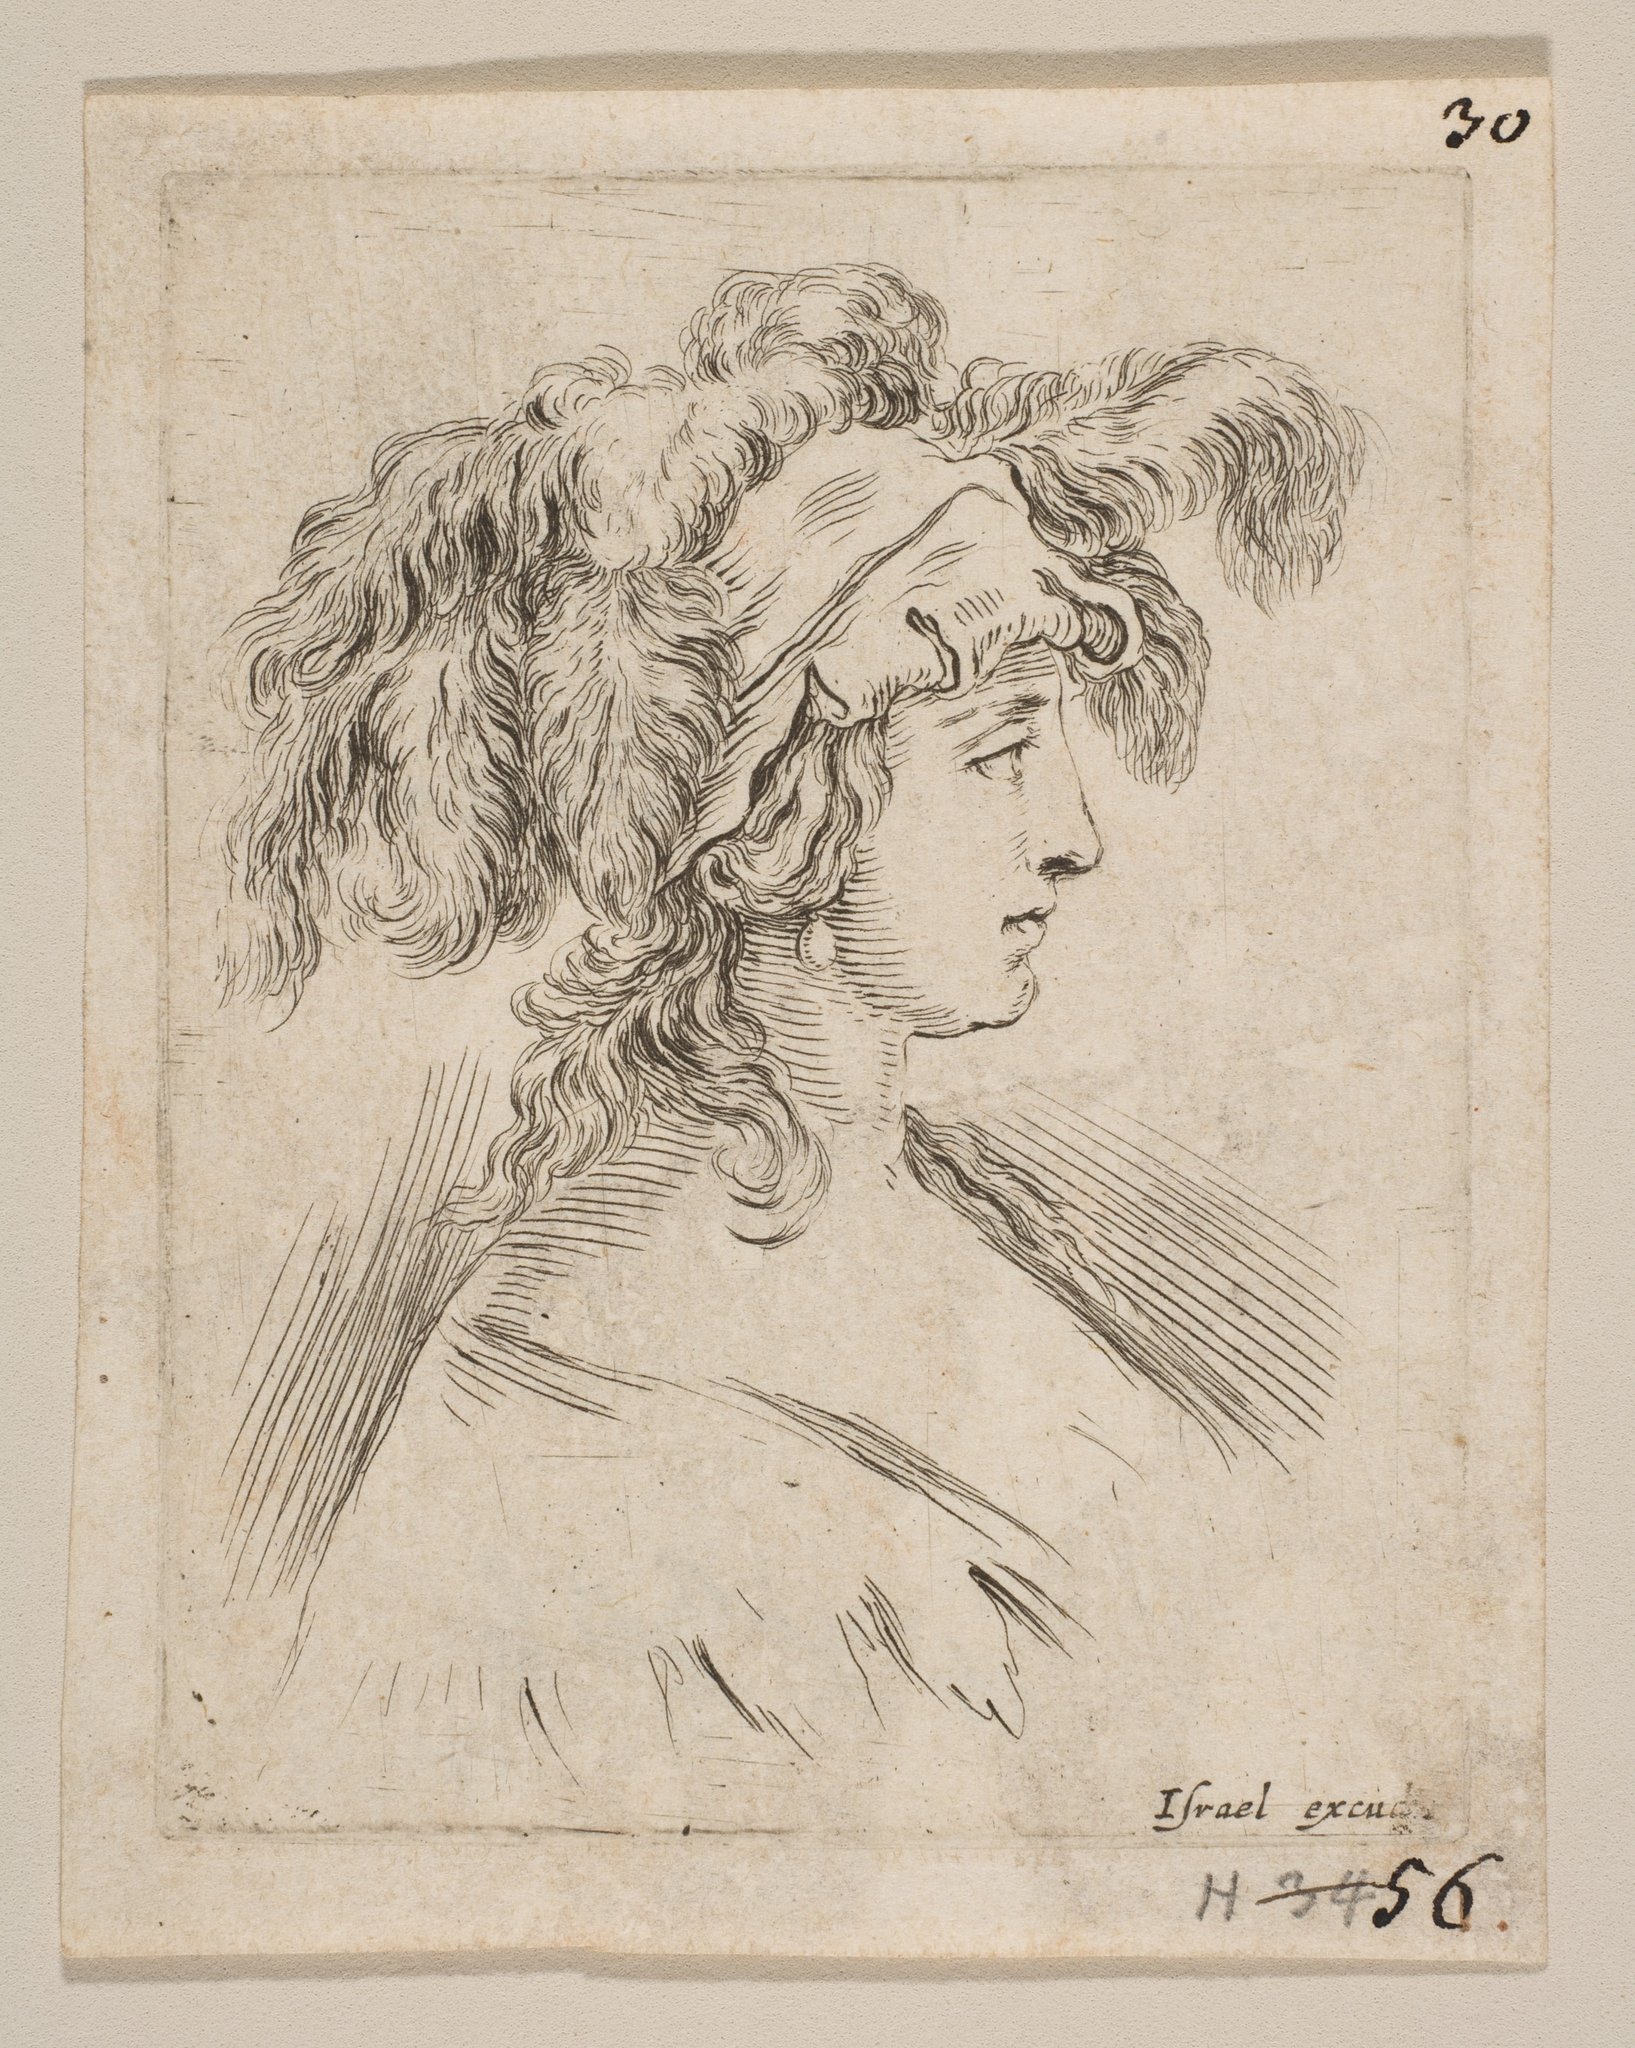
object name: print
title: Plate 15: mid-bust of a young woman in profile wearing a hat topped with feathers, from 'The Book for Learning to Draw' (Livre pour apprendre à dessiner)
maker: stefano della bella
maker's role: artist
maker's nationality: italian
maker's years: 1610-1664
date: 1649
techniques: etching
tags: profiles,women